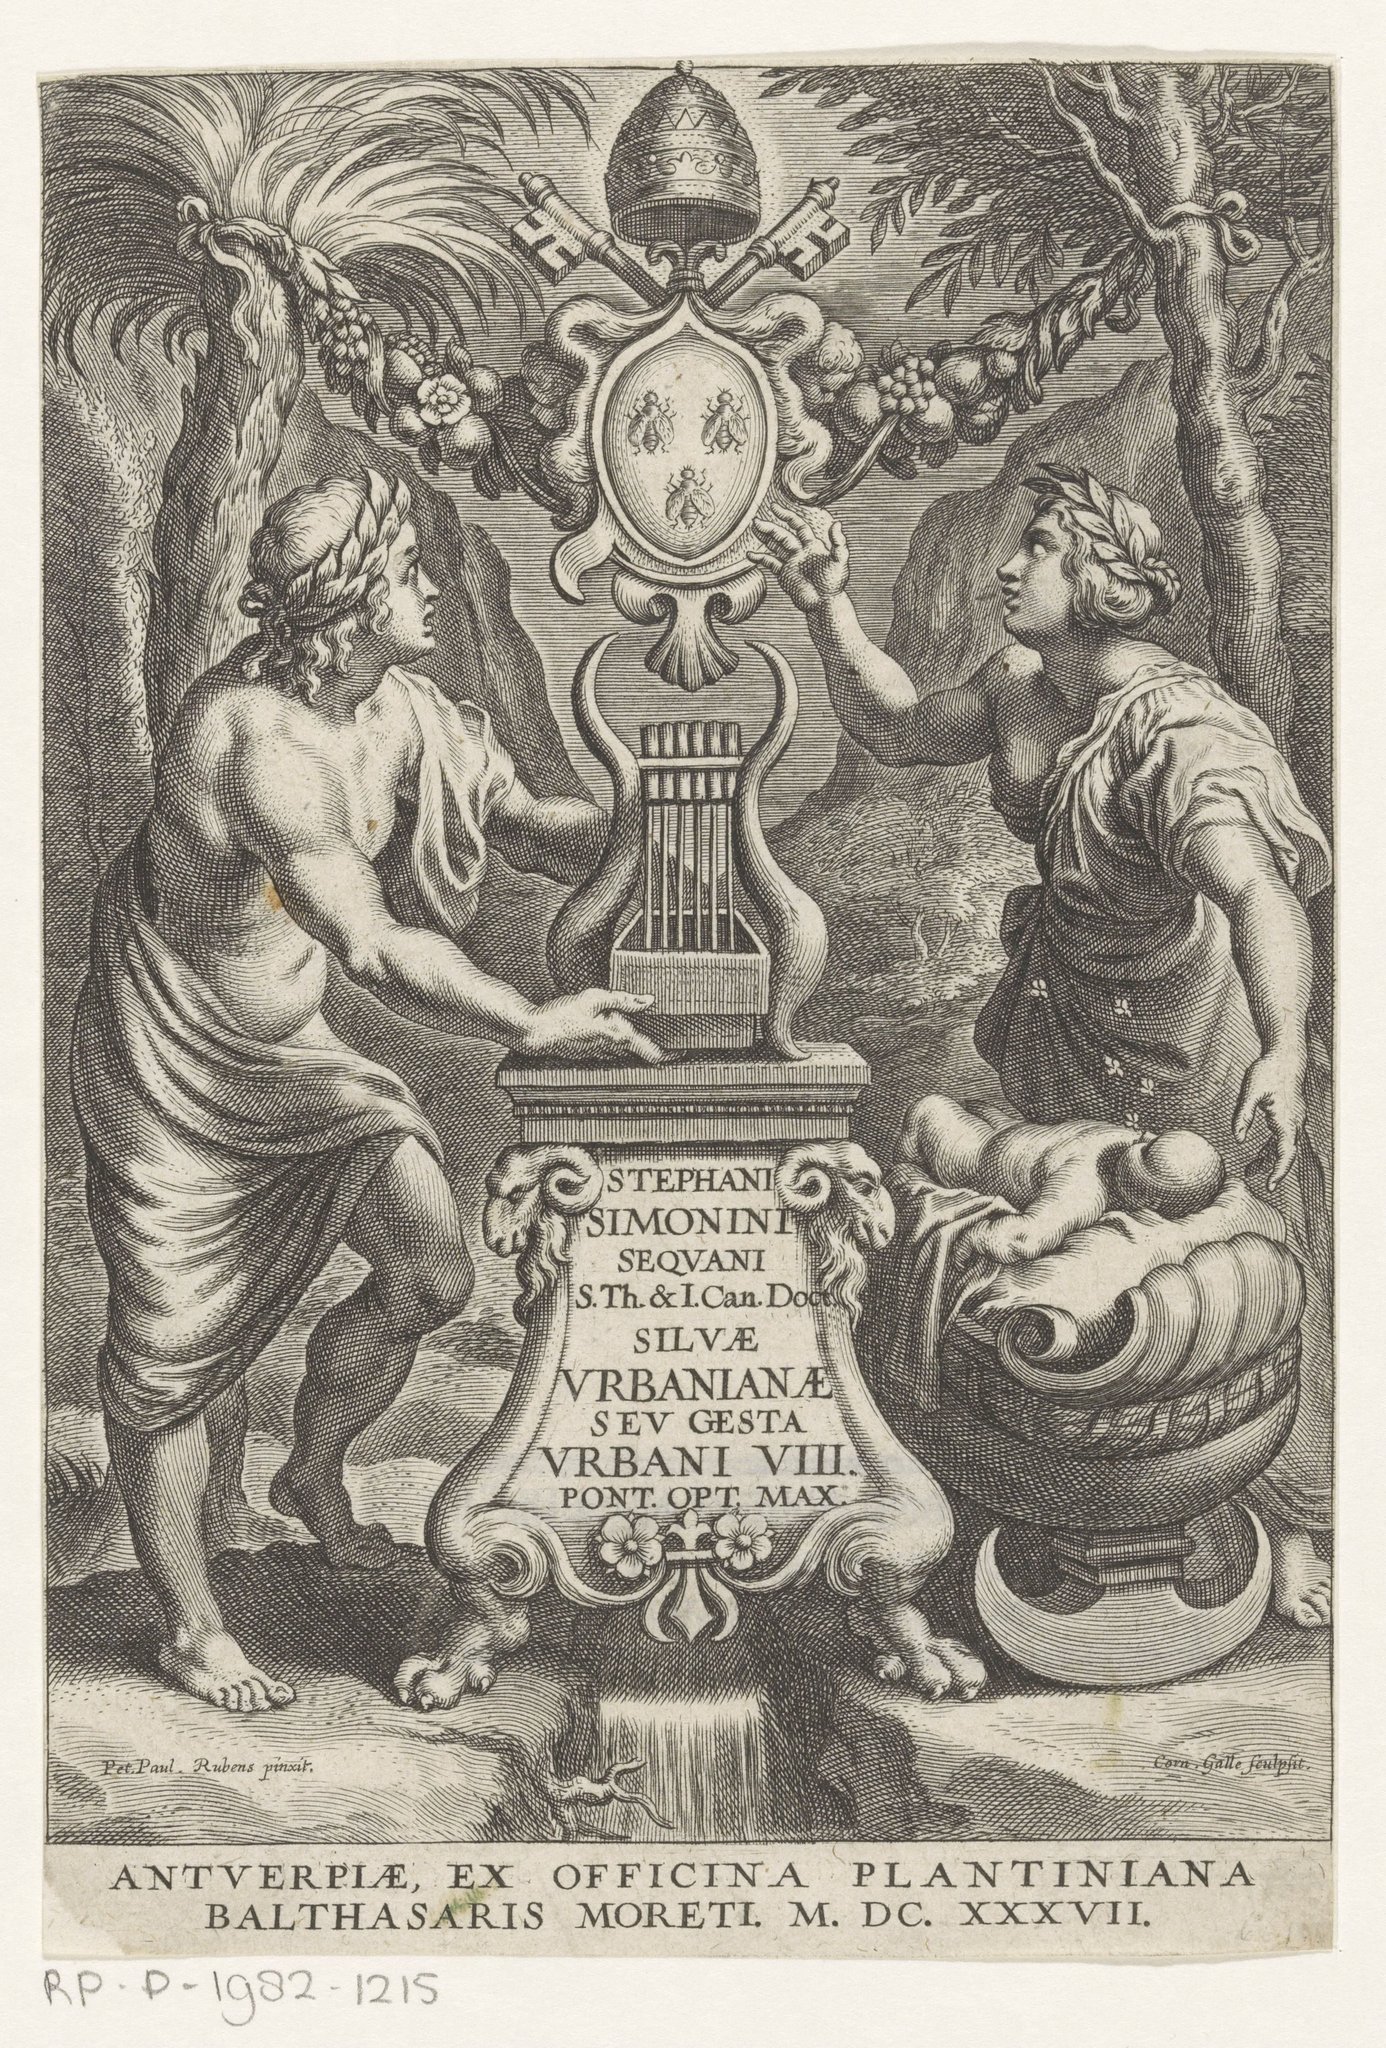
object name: titelblad, titelpagina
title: Titelpagina voor: Stephanus Simonini, Silvae Urbanianae, 1637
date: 1637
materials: paper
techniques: engraving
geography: antwerp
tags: (story of) apollo (phoebus), erato (one of the muses); 'erato' (ripa), altar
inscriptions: collector's mark: Lugt 2760, collector's mark: Lugt 2228, stamp: ‘'Victoria and Albert Museum' / sold by order of the minister of education’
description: Apollo, de god van poëzie, plaatst zijn lier op een altaar. Rechts staat Erato, de muze van de lyrische poëzie, naast een wieg waarin een baby ligt. De baby is waarschijnlijk de Griekse dichter Pindarus. Onder het altaar de bron van Hippocrene. Aan de bovenzijde een guirlande met het wapen van het geslacht Barberini, de pauselijke tiara en sleutels.